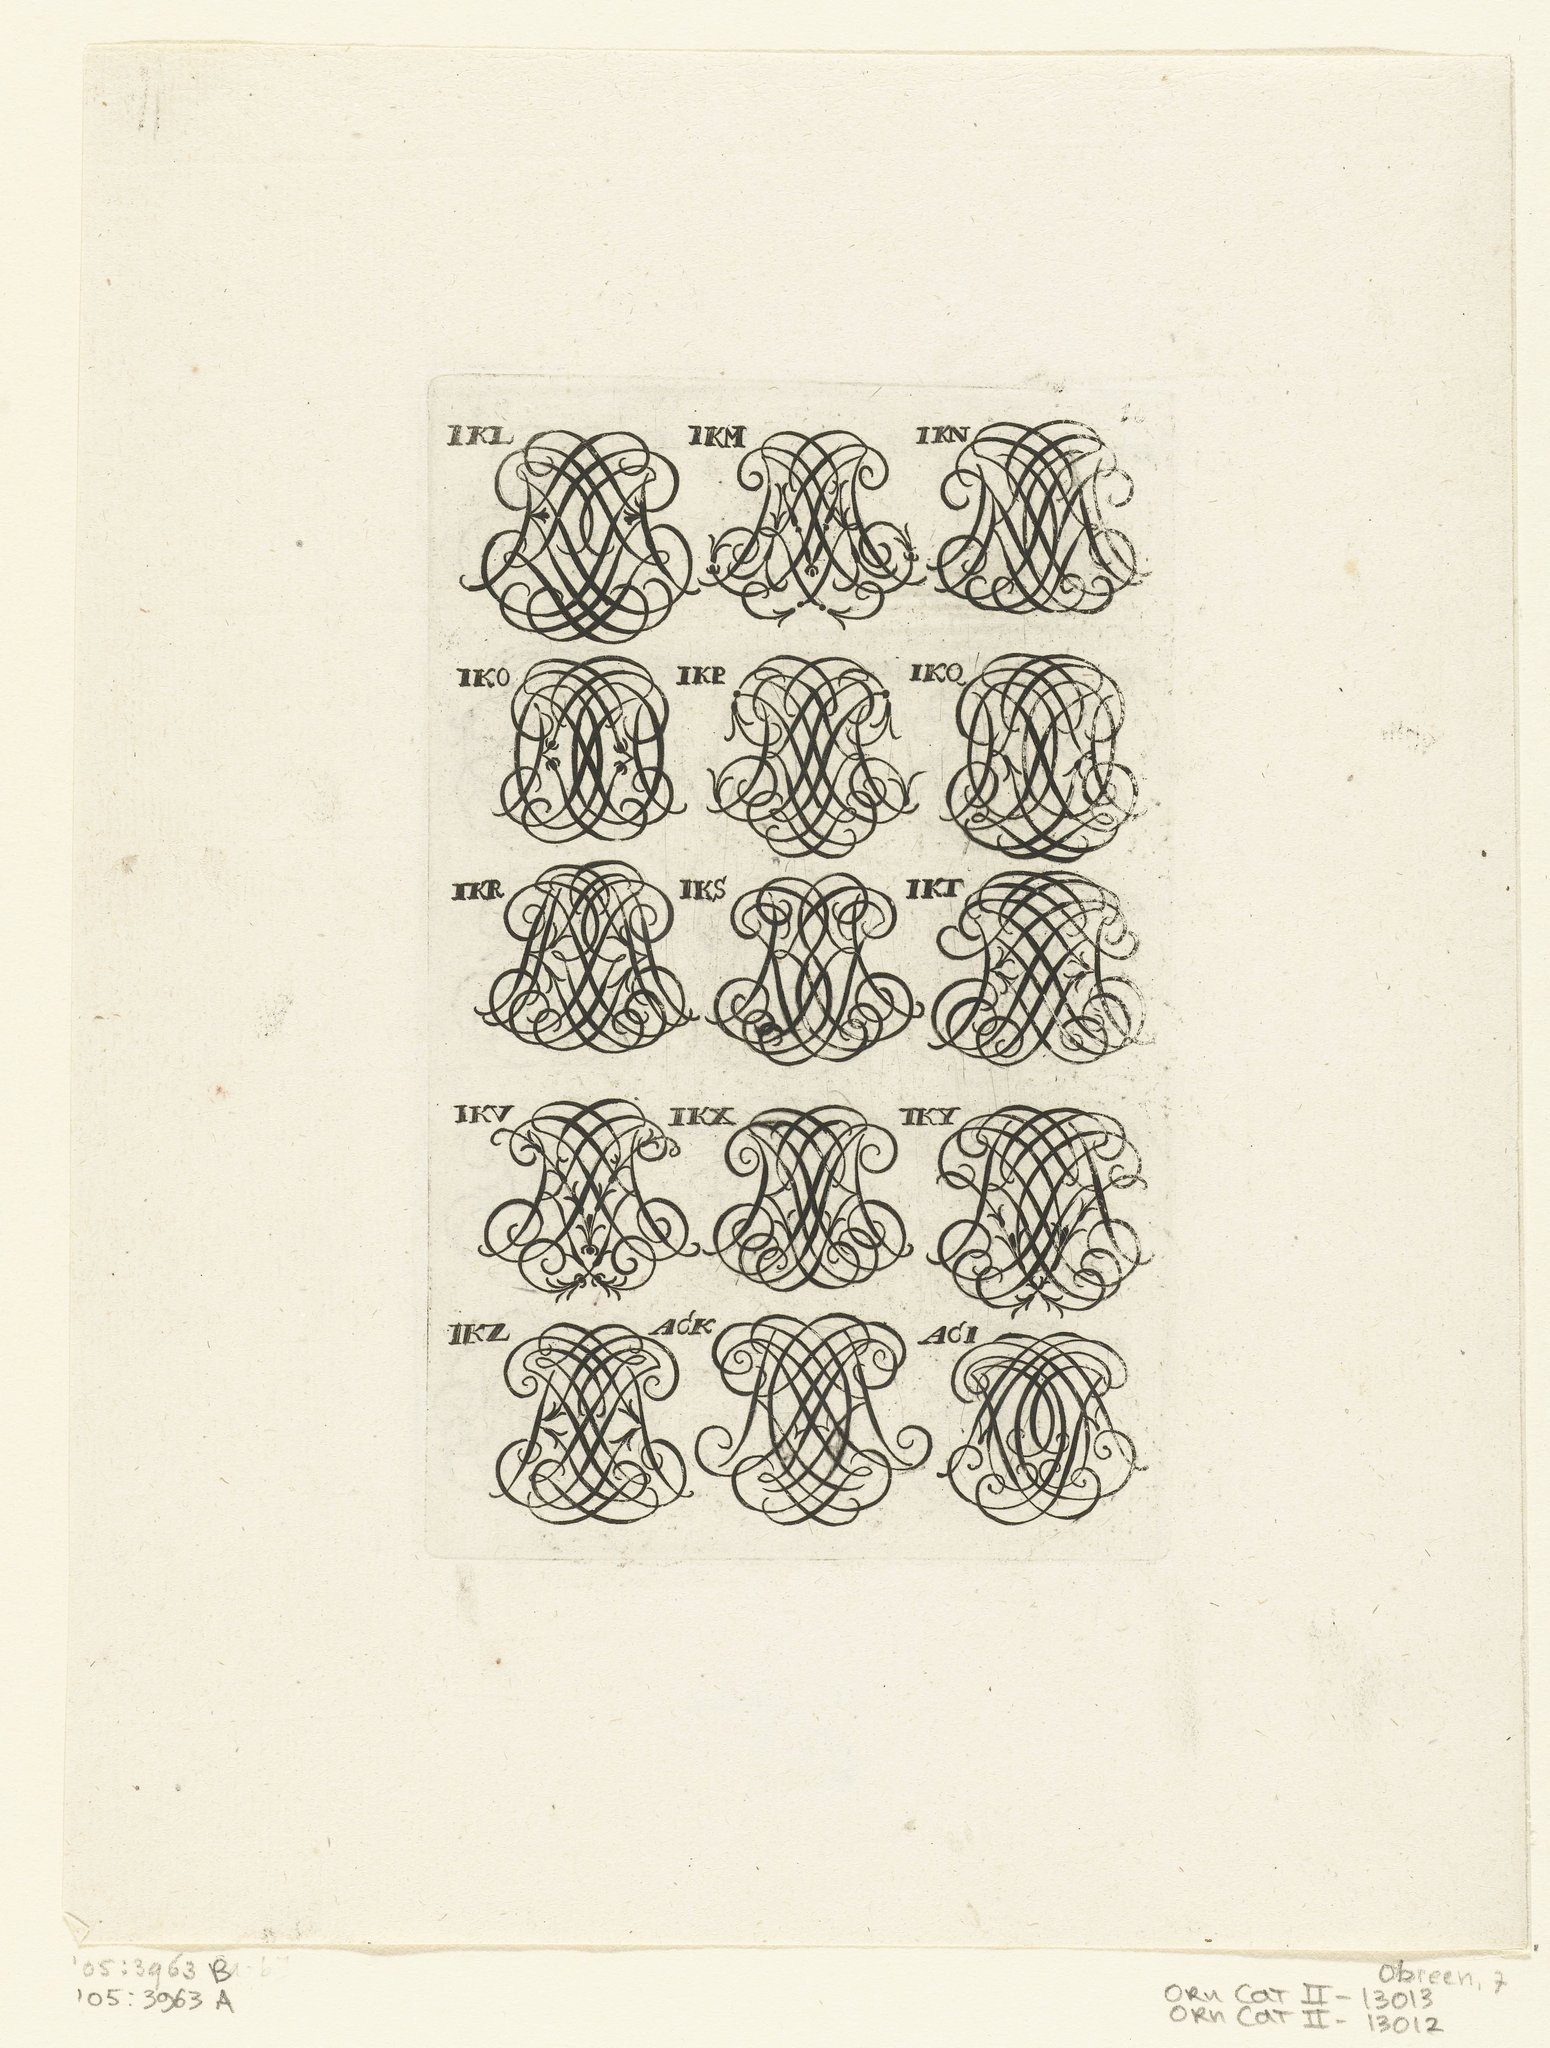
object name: print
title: Livre nouveau et utile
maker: daniel de lafeuille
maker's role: print maker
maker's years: 1640-1709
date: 1690-1691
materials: paper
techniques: engraving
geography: amsterdam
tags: letters, alphabet, script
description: Uit serie van 29 deels genummerde bladen met cijfermonogrammen.